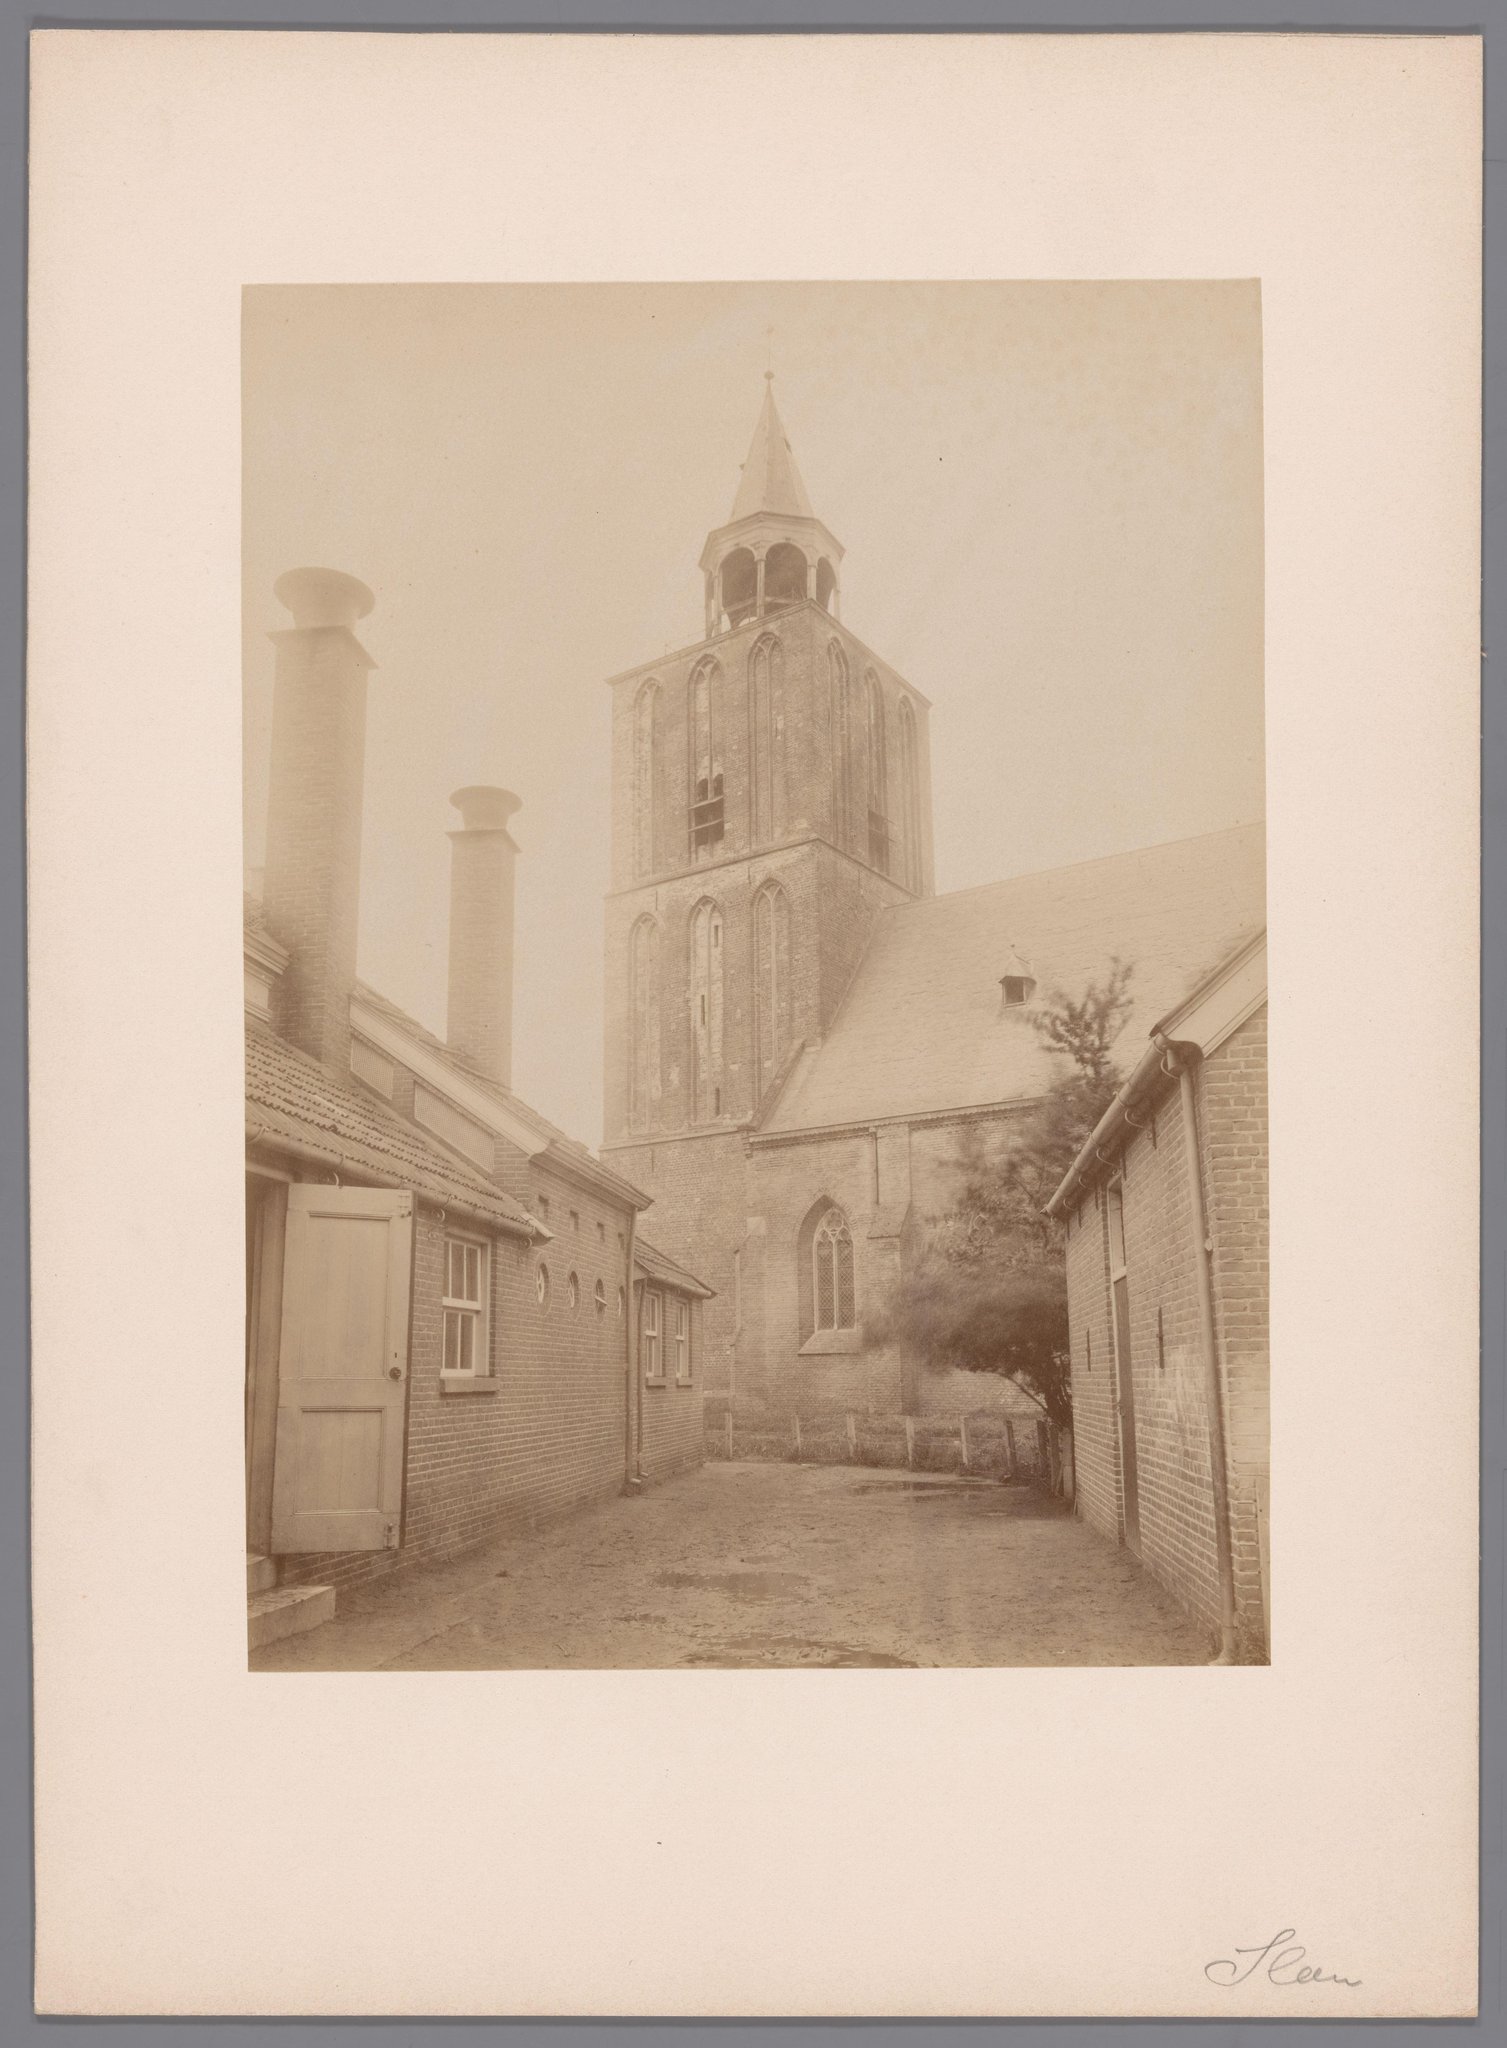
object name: photograph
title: Toren van de Hervormde Kerk te Sleen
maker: anoniem (monumentenzorg)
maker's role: fotograaf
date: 1903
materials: cardboard, photographic support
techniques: albumen print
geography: sleen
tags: parts of church exterior and annexes: tower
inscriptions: annotation: ‘Sleen (Drenthe)/ Toren van & aan den kerk er N.H. gemeente/ juli 1903’, annotation: ‘Sleen’